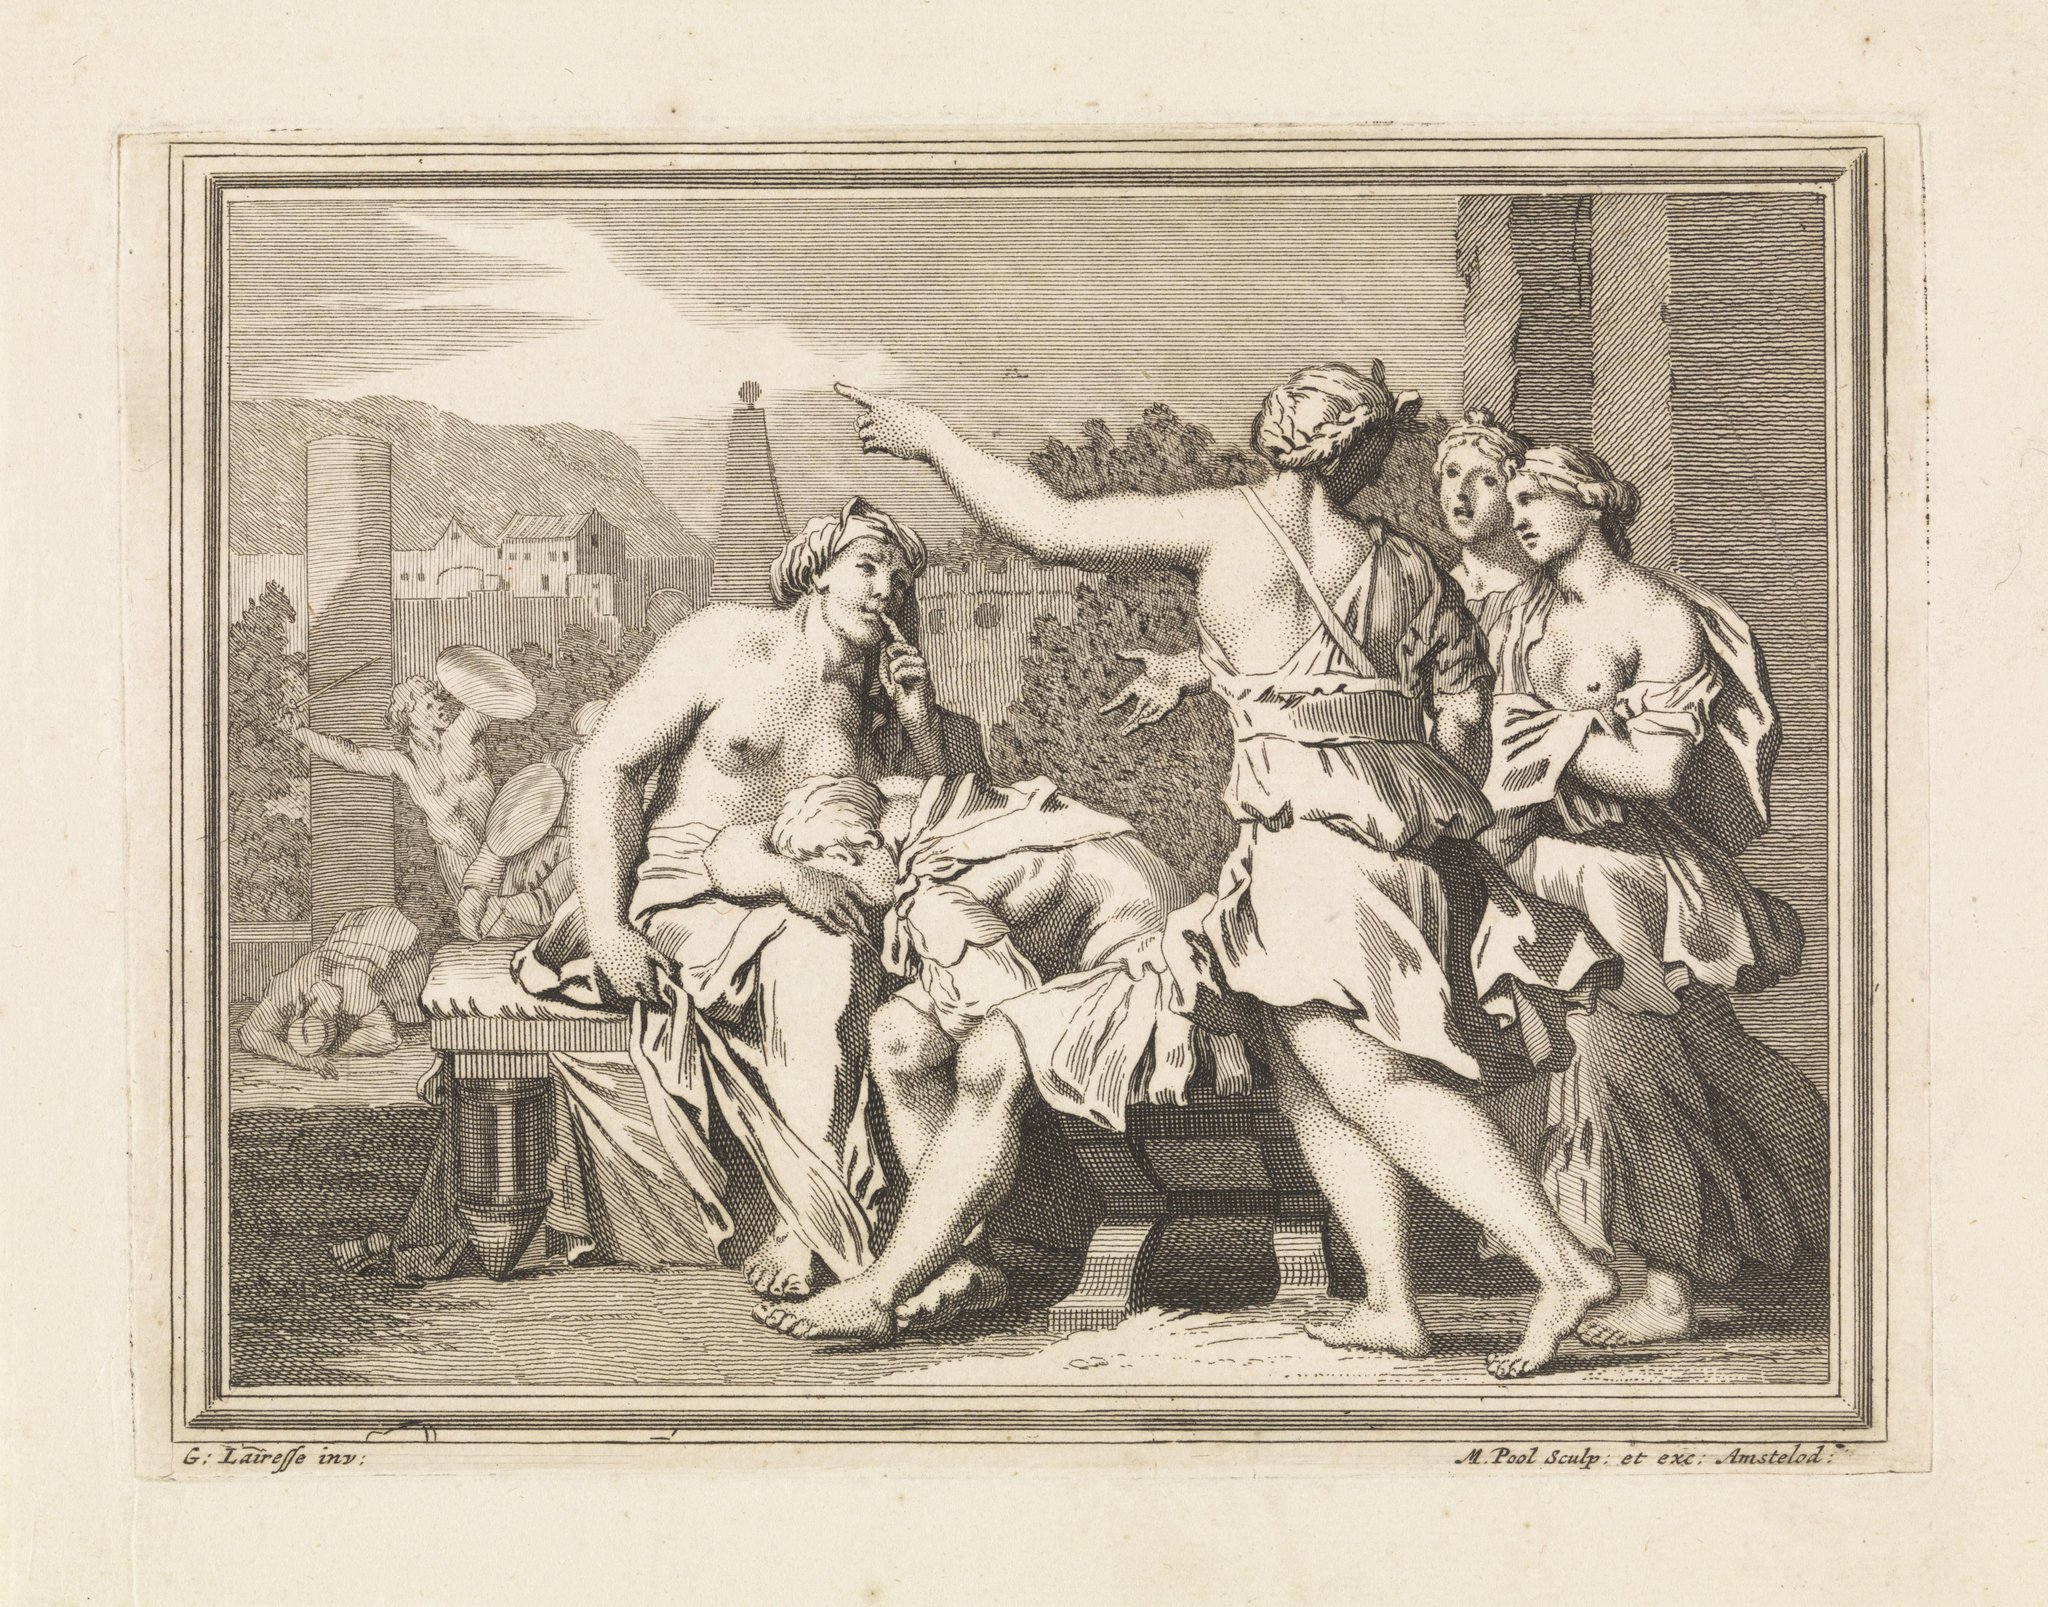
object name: print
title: Italiaans landschap met treurende vrouwen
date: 1696-1727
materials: paper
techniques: engraving, etching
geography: amsterdam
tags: battle, fighting in general, mourning the dead, landscapes - hh - ideal landscapes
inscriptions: collector's mark: Lugt 240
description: Vijf vrouwen in klassieke gewaden treuren bij een tombe. Eén van hen wijst naar links. Op de achtergrond vechtende soldaten.